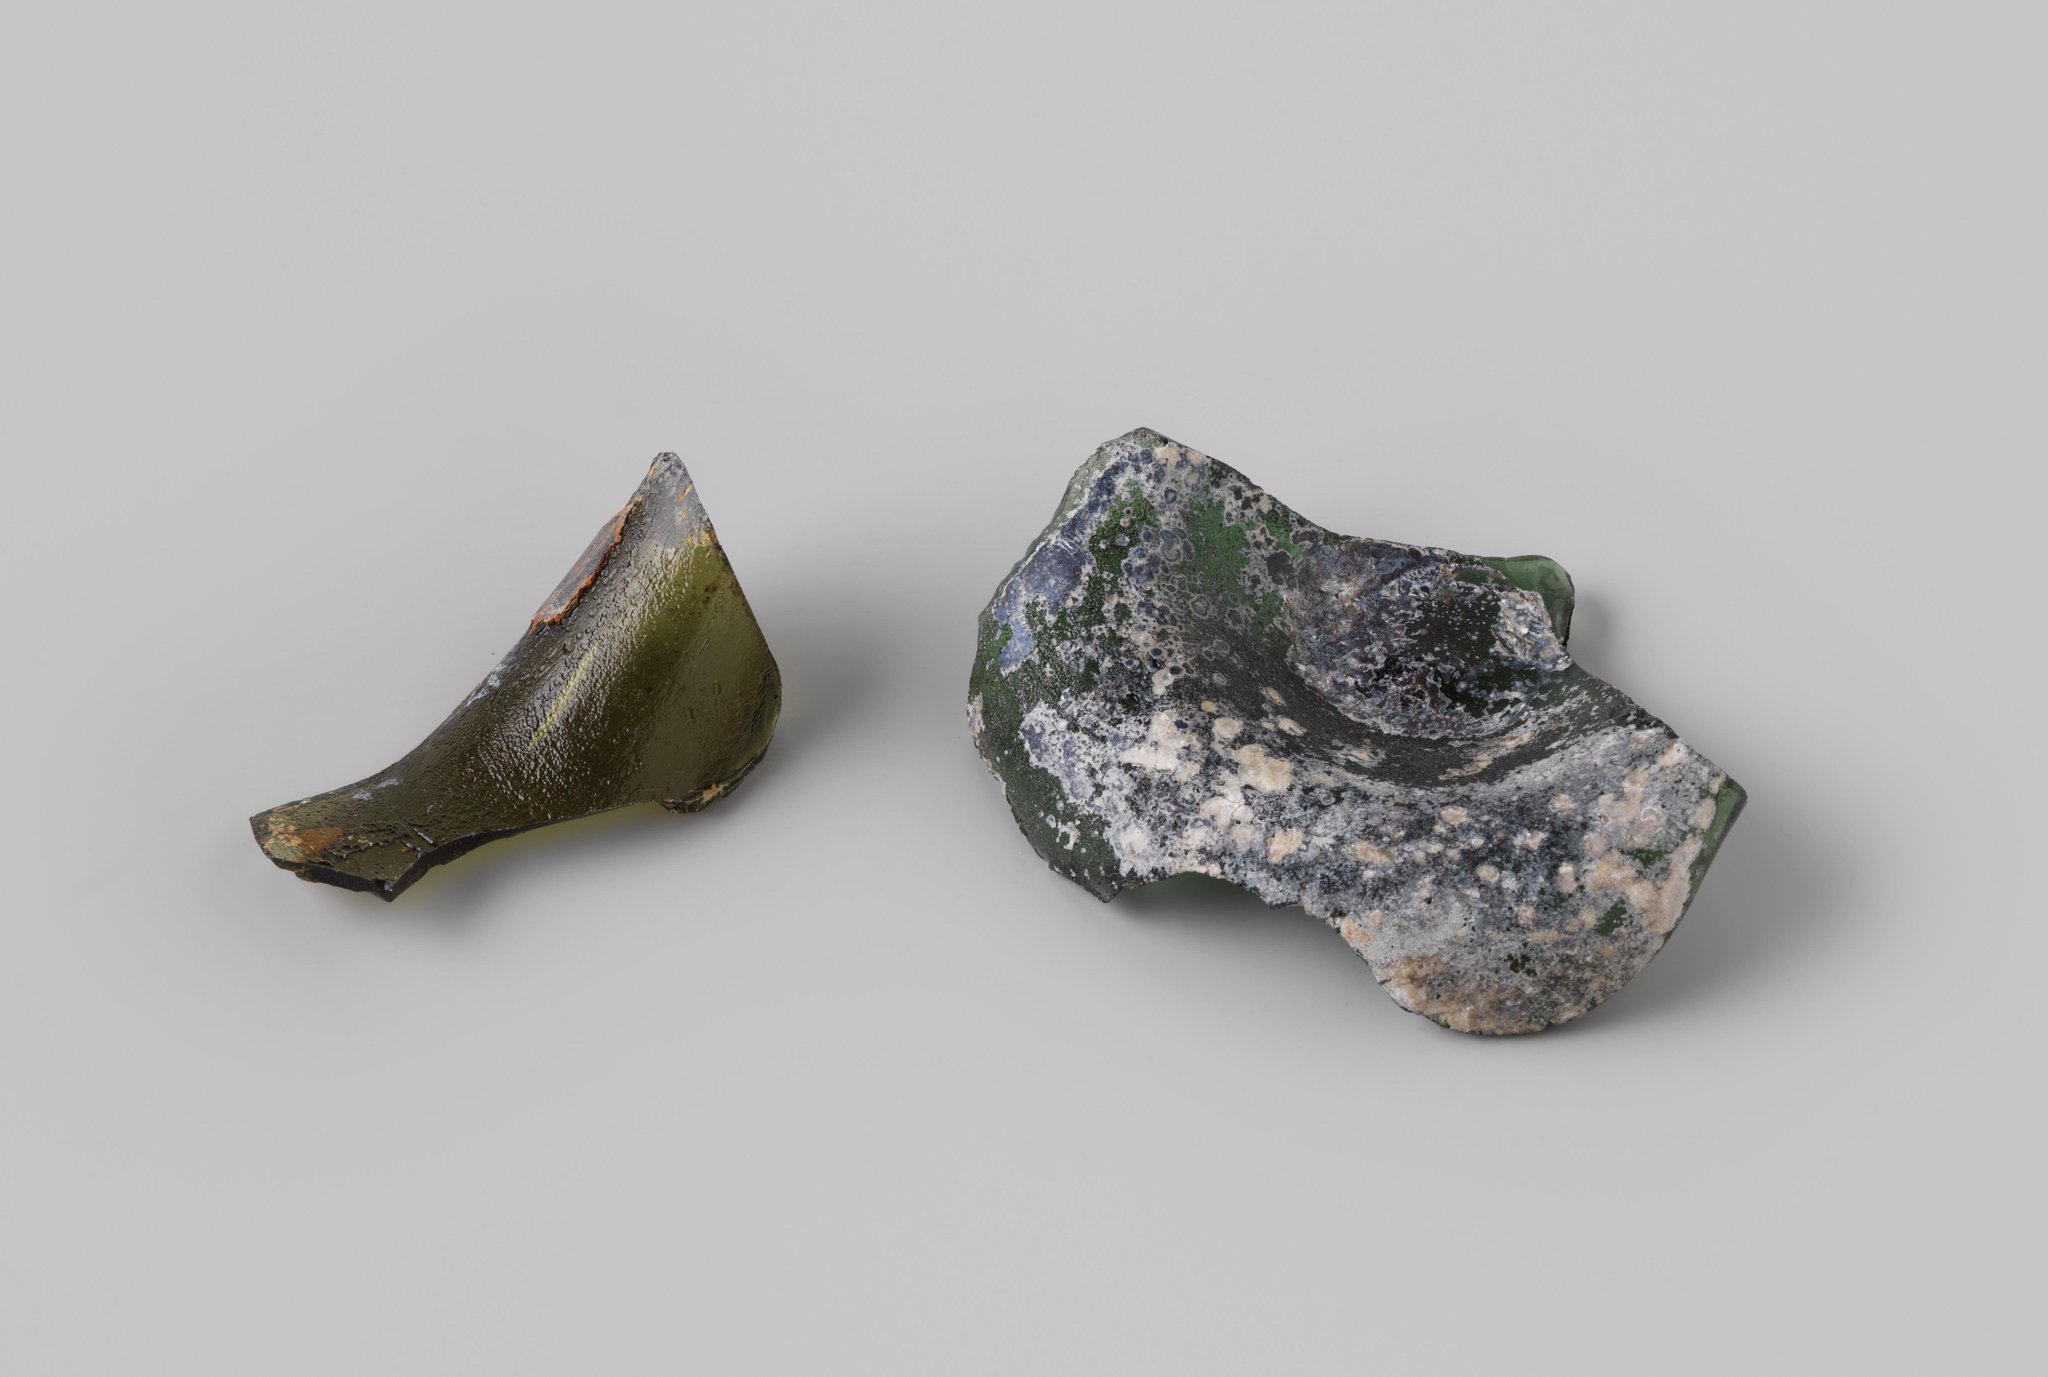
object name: wine bottle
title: Scherven van wijnflessen uit het wrak van de Oostindiëvaarder 't Vliegend Hart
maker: Anonymous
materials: glass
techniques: green glass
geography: netherlands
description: Scherven van uivormige wijnflessen van groen glas waar rode (port)wijn in heeft gezeten.